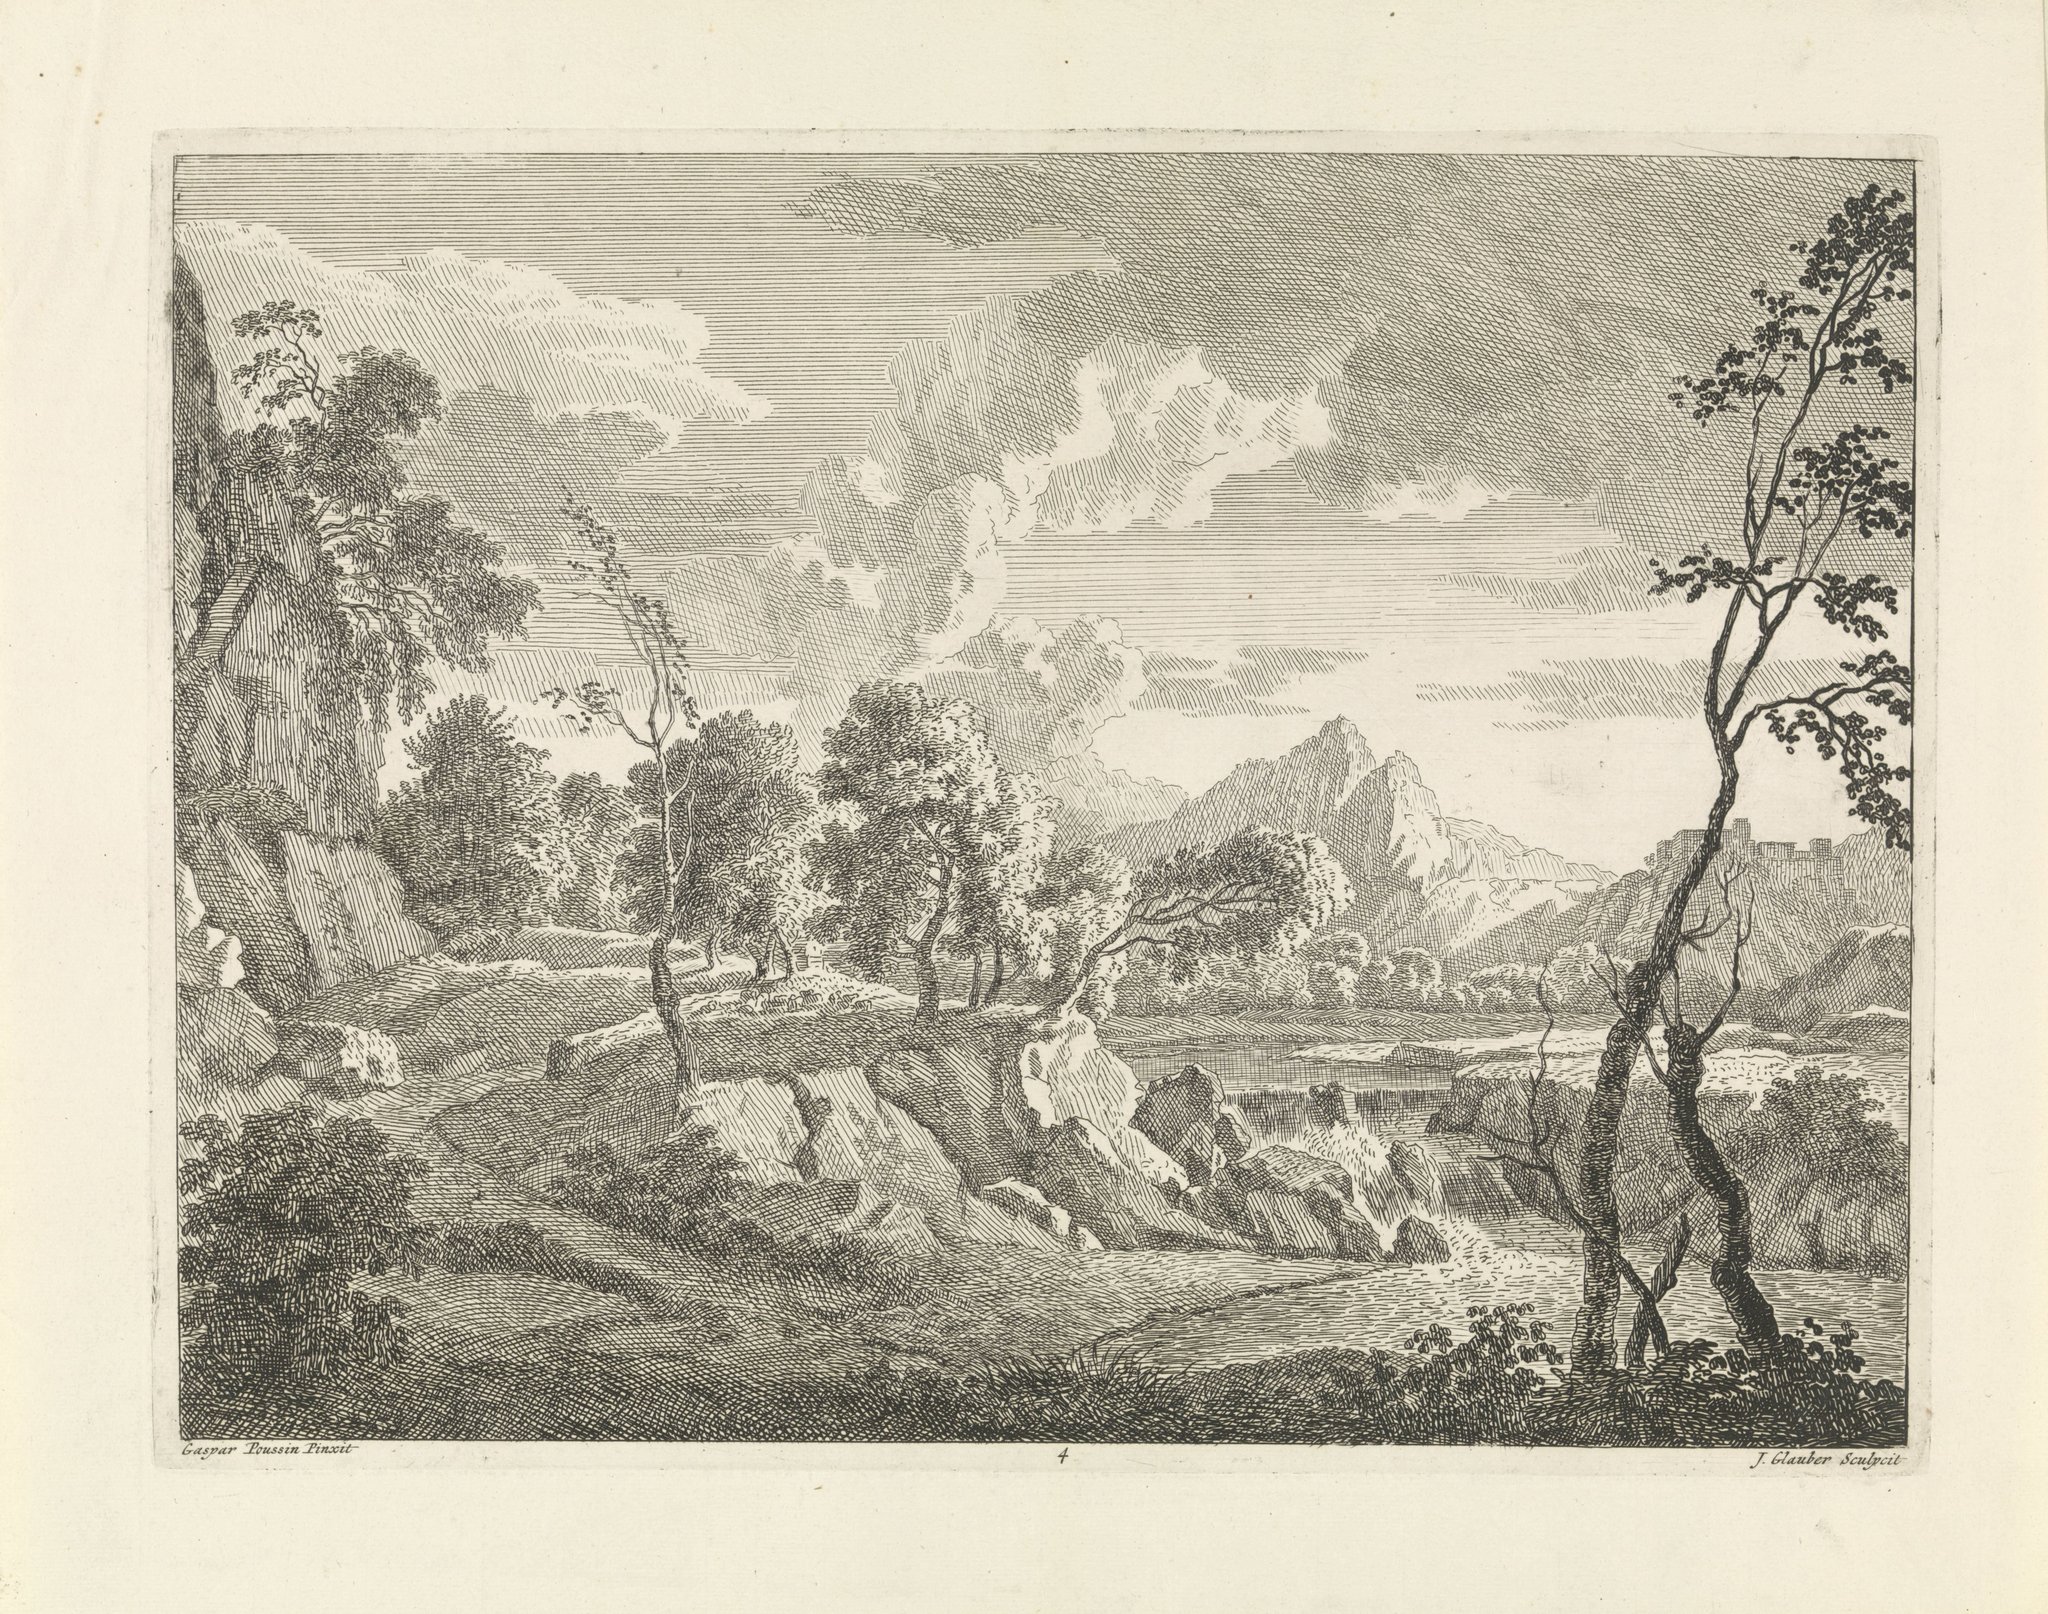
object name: print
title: Landschappen naar Gaspar Poussin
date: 1656-1726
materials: paper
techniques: etching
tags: waterfall, (high) hill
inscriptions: collector's mark: Lugt 240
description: Heuvelachtig landschap met op de voorgrond een waterval die uitmondt in een vijver. De prent maakt deel uit van een serie van landschappen naar schilderijen van Gaspar Poussin.